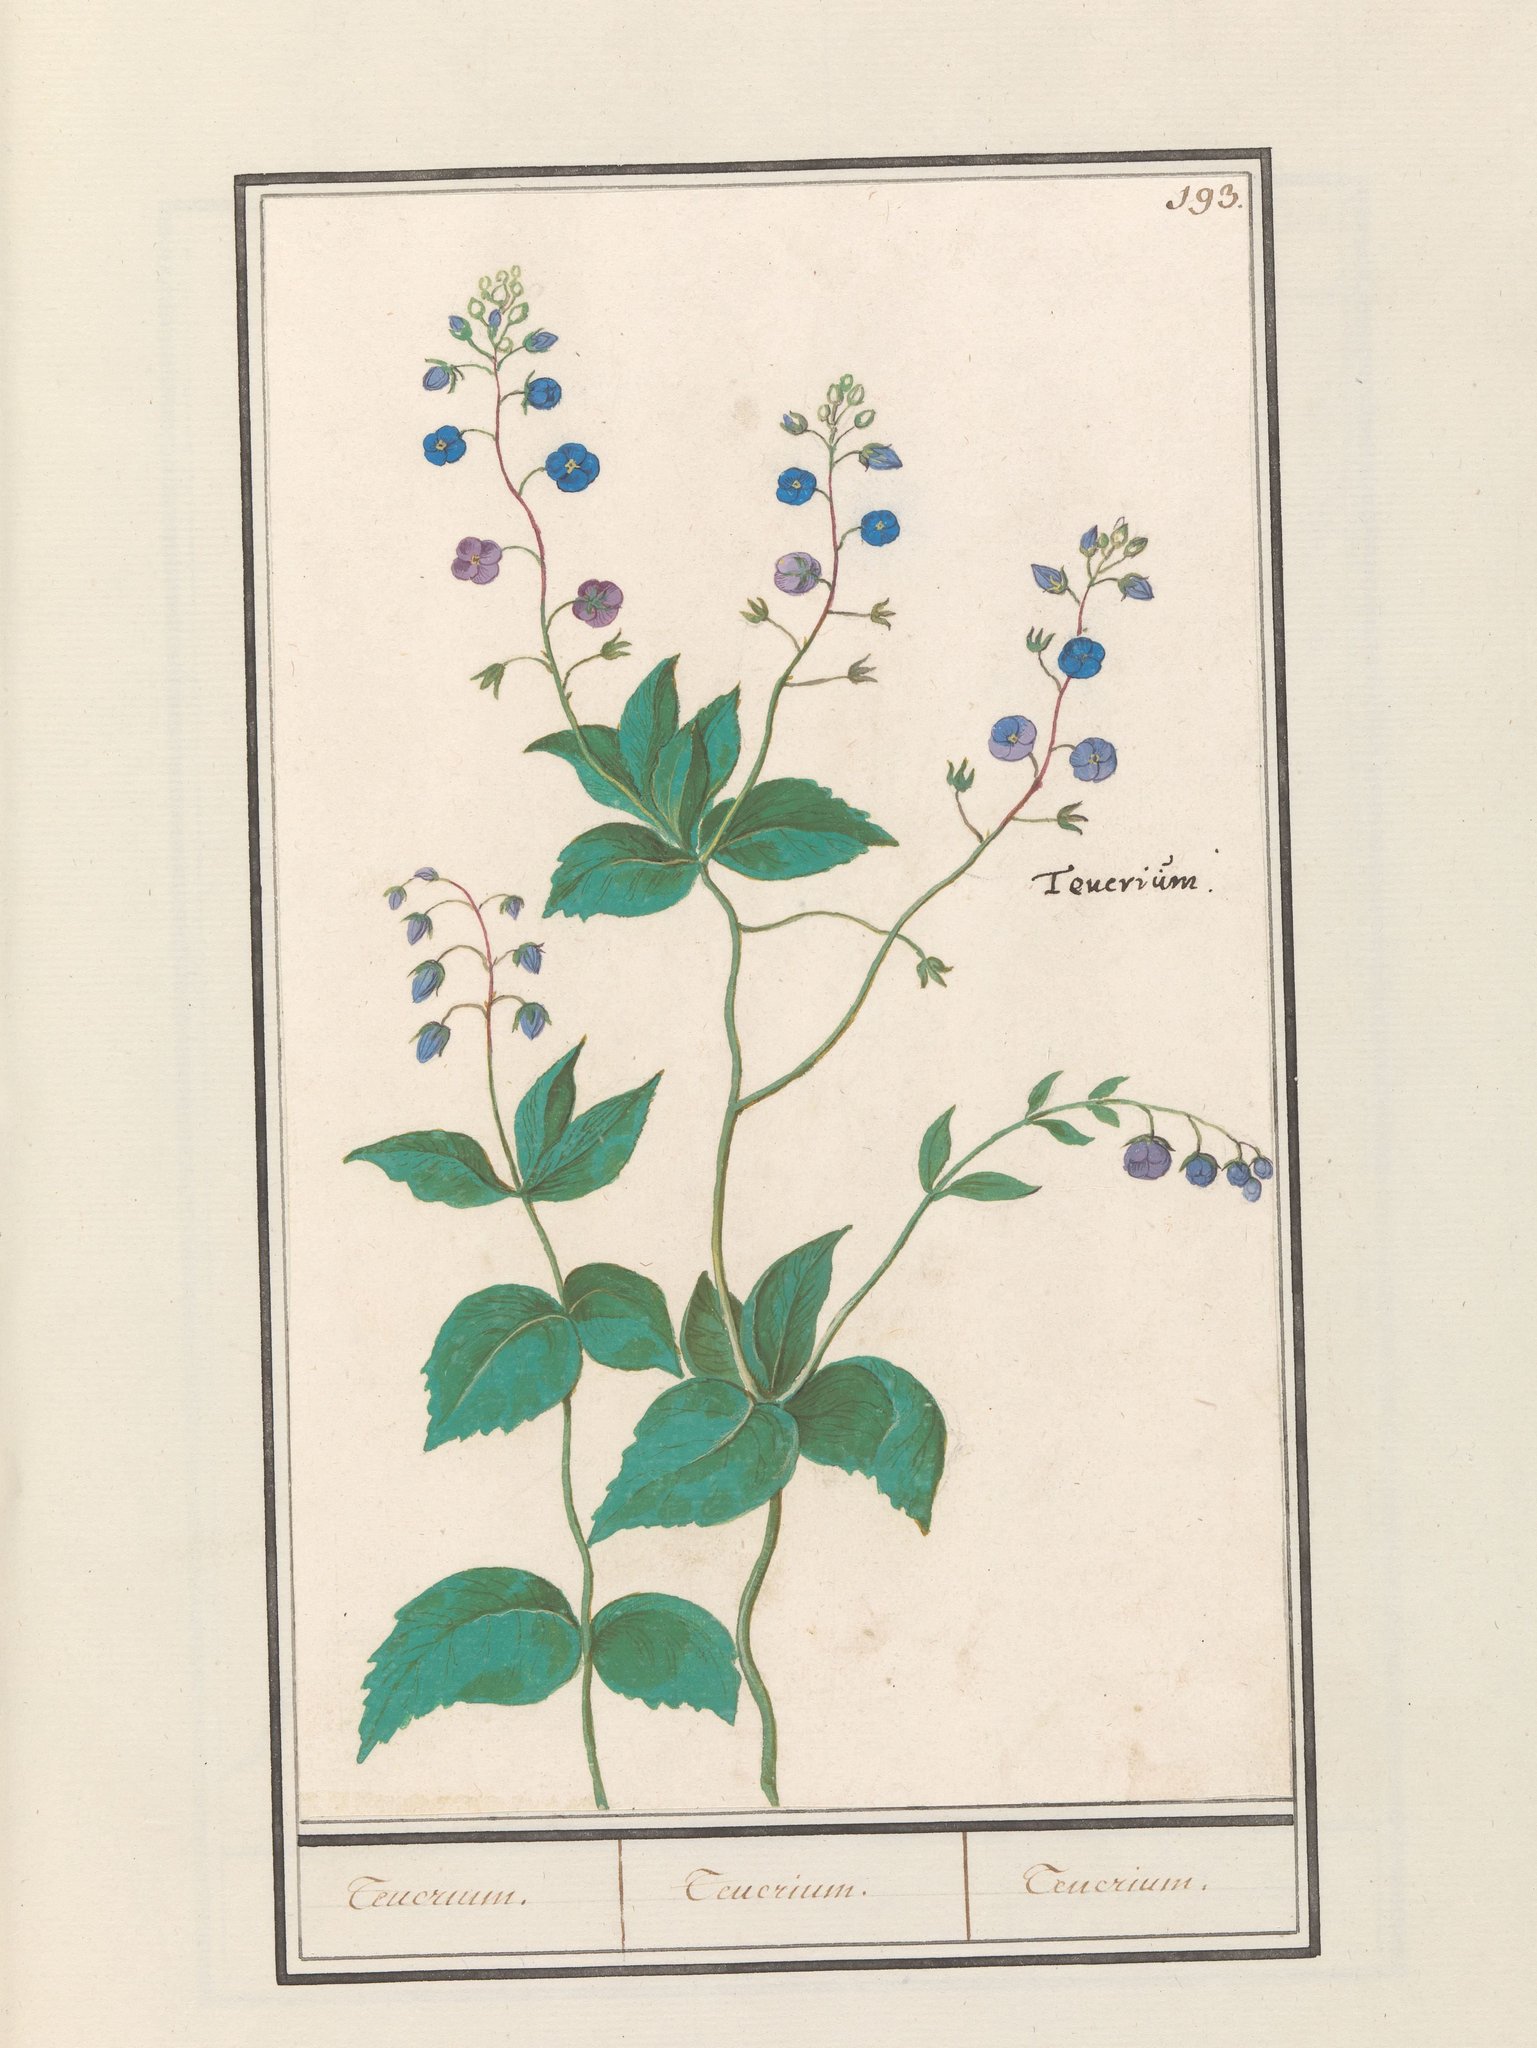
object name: drawing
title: Teuerium. / Teuerium. / Teucrium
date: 1596-1610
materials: chalk, paint, ink, paper, watercolor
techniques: brush, pen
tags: flowers: germander speedwell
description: Gewone ereprijs. Rechtsboven genummerd: 193. Rechts de Latijnse naam. Onderdeel van het tweede album met tekeningen van bloemen en planten. Negende van twaalf albums met tekeningen van dieren, vogels en planten bekend rond 1600, gemaakt in opdracht van keizer Rudolf II. Met toelichting in Nederlands, Latijn en Frans.